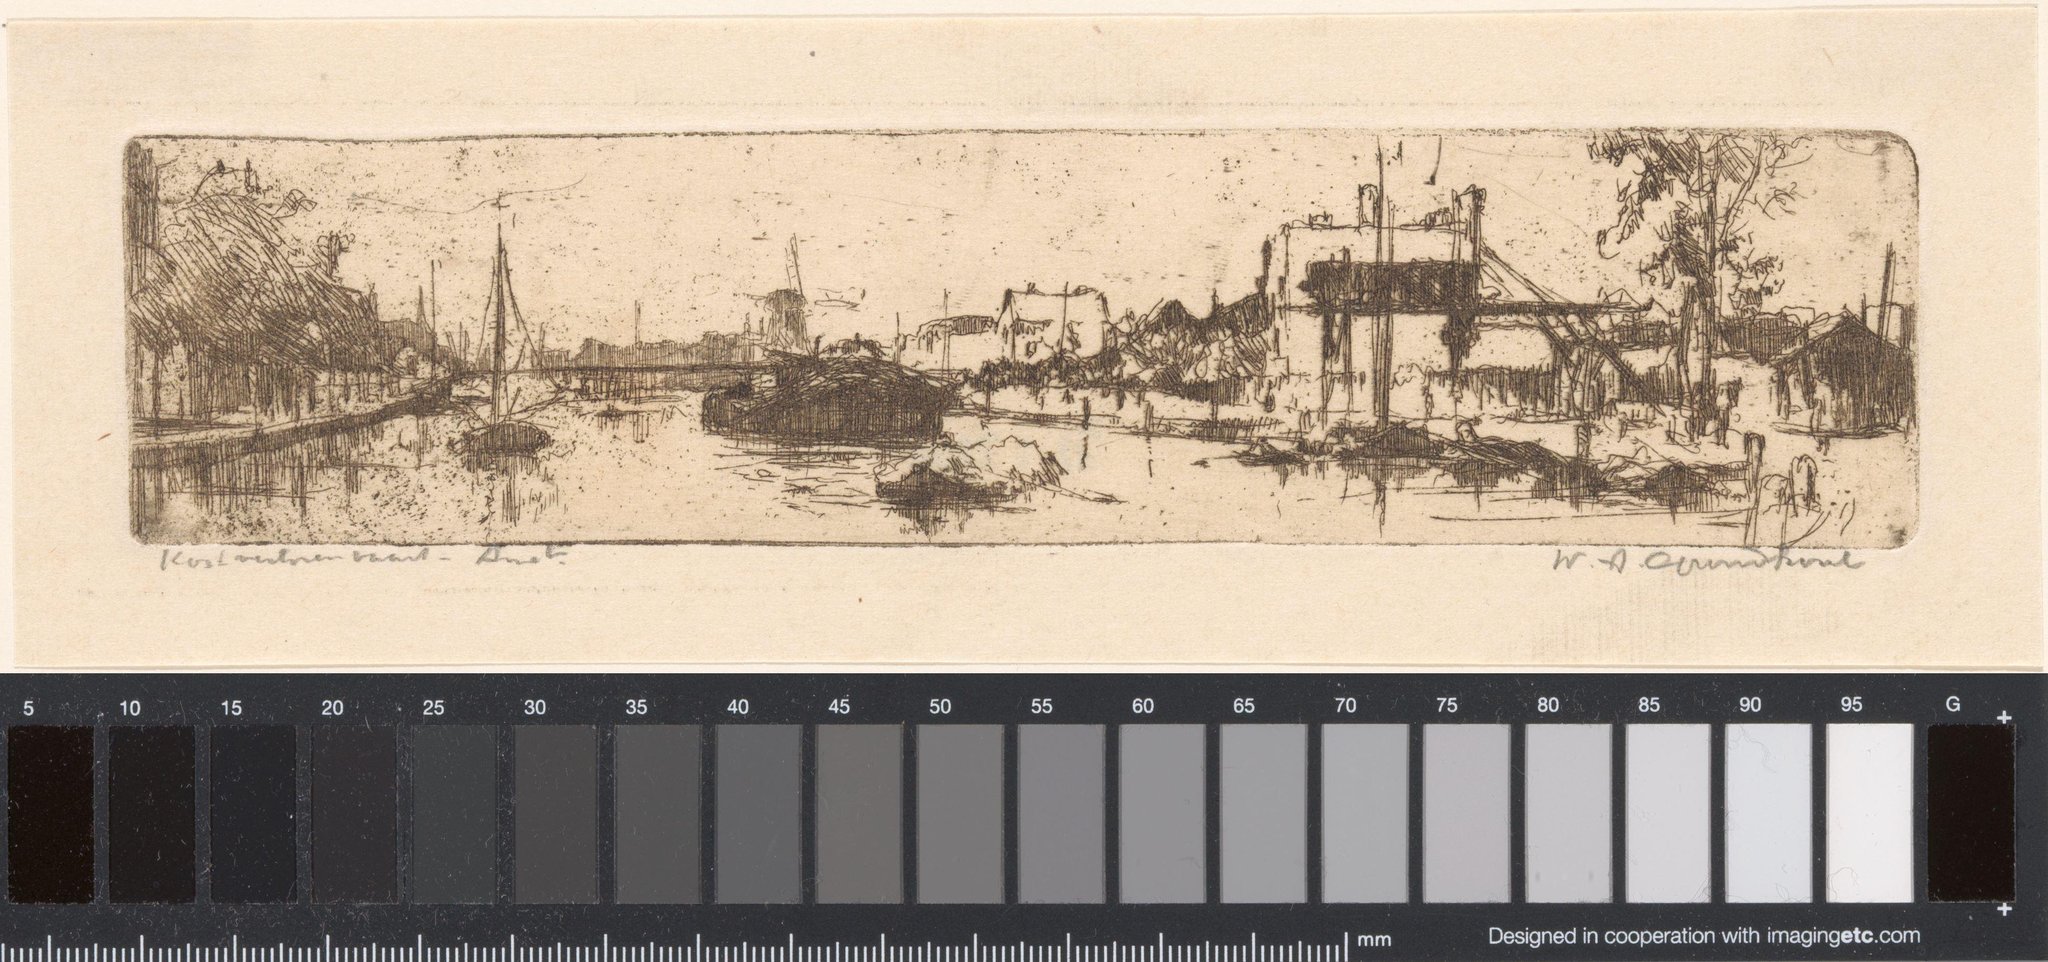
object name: print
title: Kostverlorenvaart, Amsterdam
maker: willem adrianus grondhout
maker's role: draughtsman, painter, print maker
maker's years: 1878-1934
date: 1888-1931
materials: paper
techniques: etching, intaglio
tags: ships (in general), canals, waters (in city)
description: Varende schepen op de Kostverlorenvaart in Amsterdam. Op de achtergrond het silhouet van een molen.